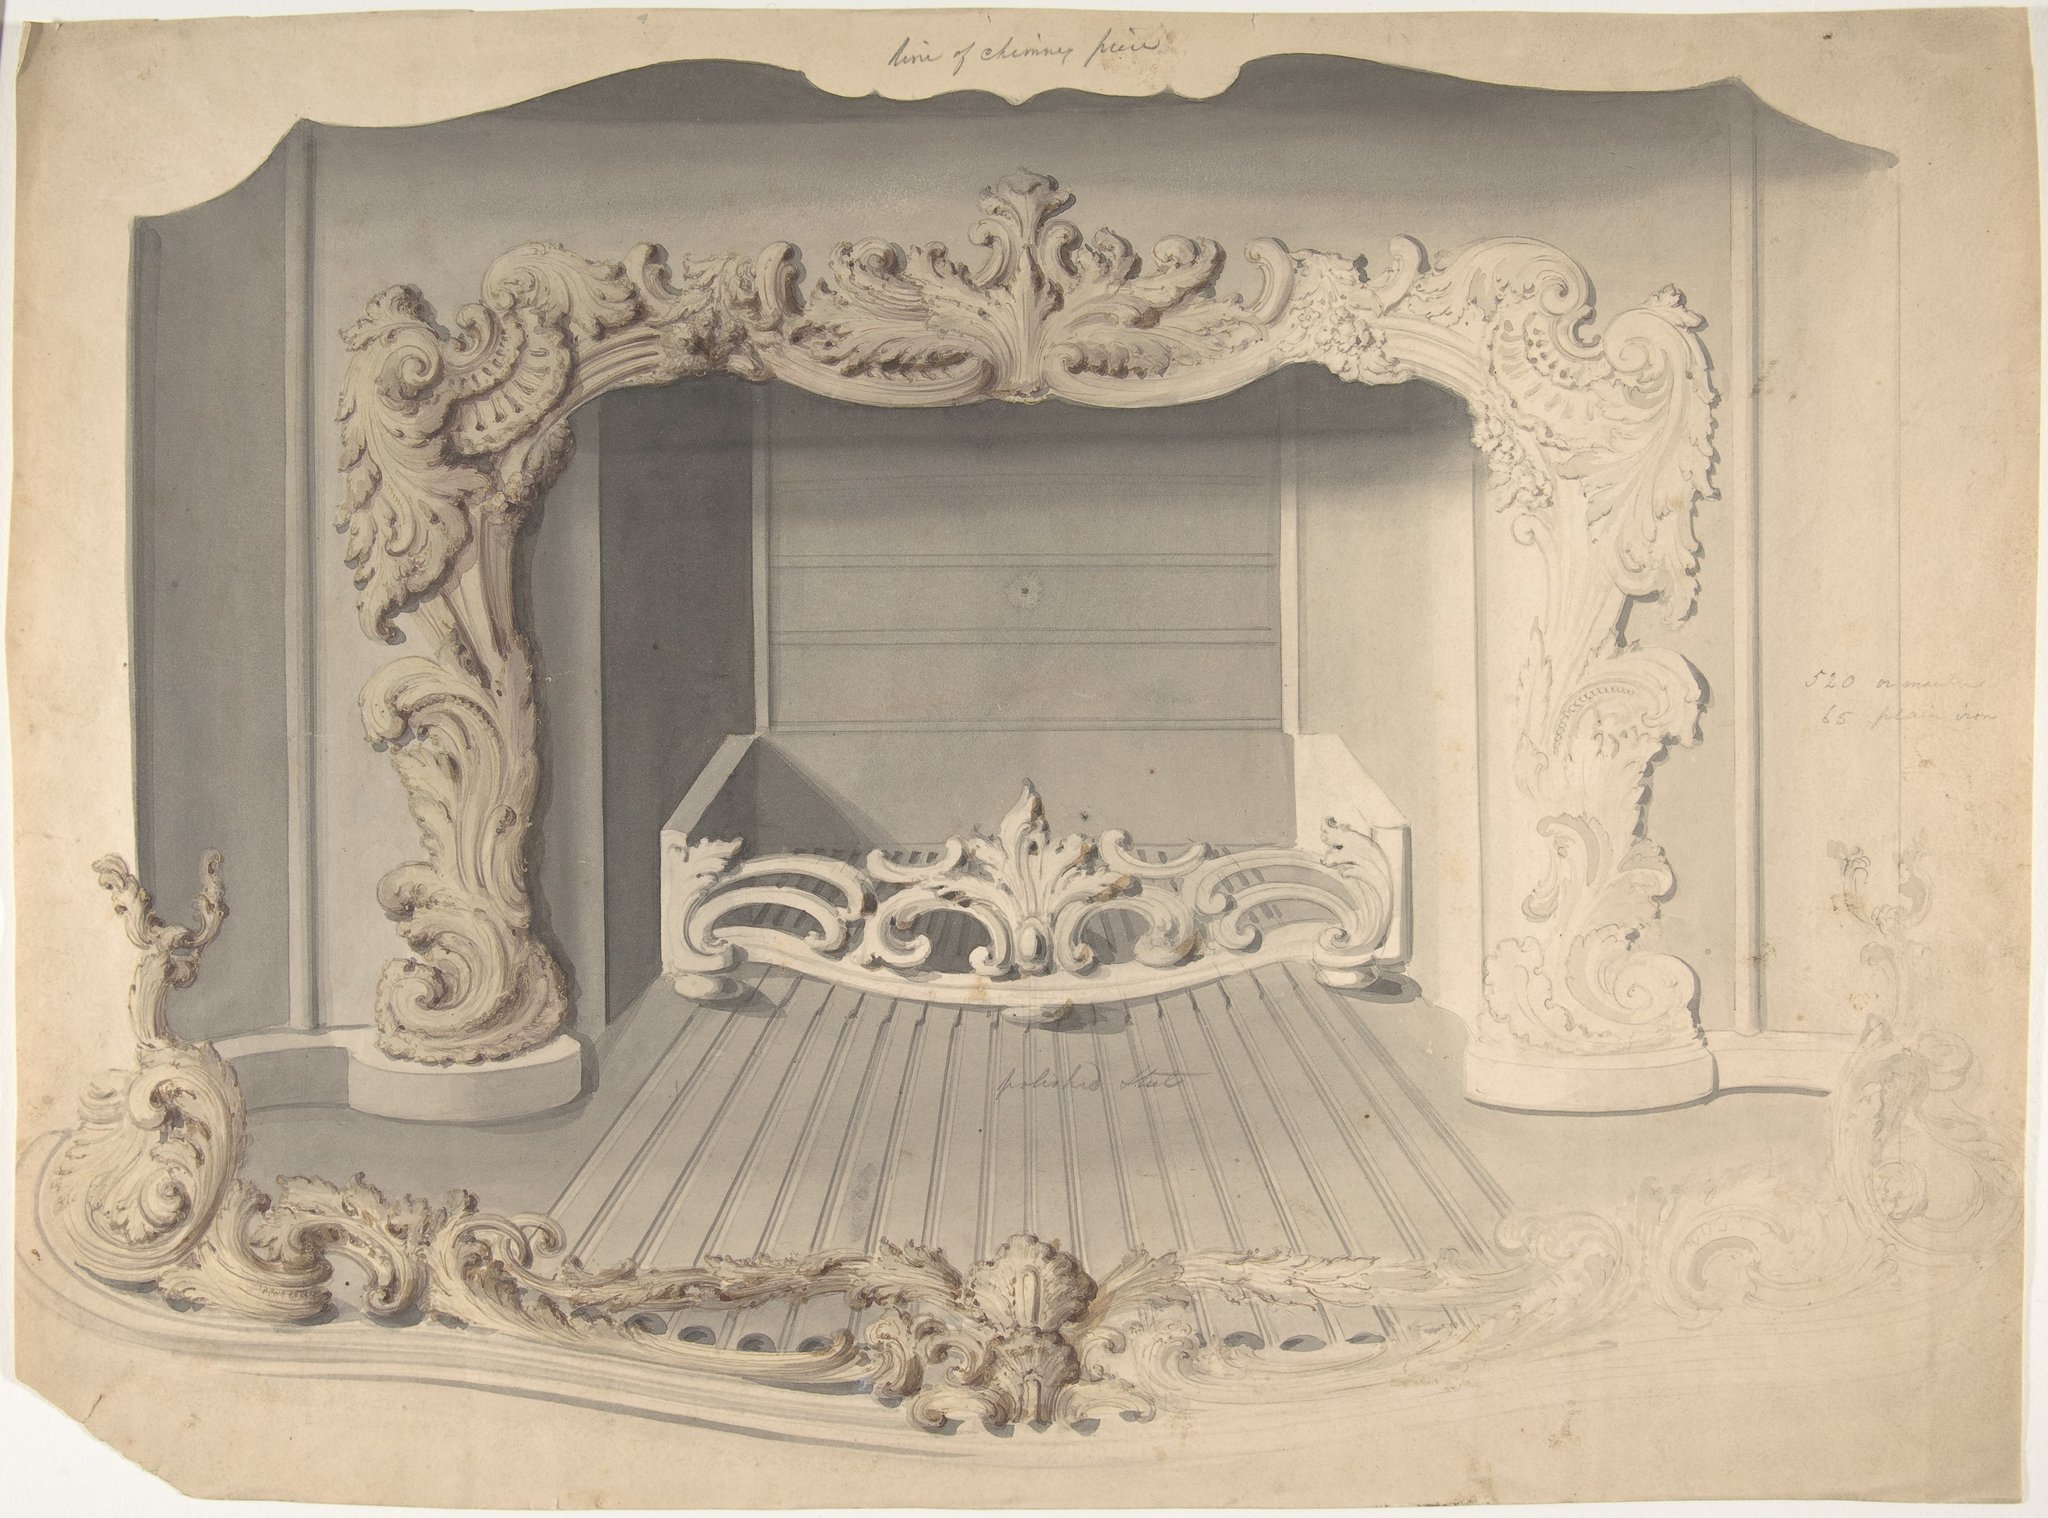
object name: drawing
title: Iron Grate with Acanthus Ornament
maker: anonymous, british, 19th century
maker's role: artist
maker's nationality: british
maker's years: 1800-1900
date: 1801-1900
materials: watercolor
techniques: brush, wash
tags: fireplaces,ornament